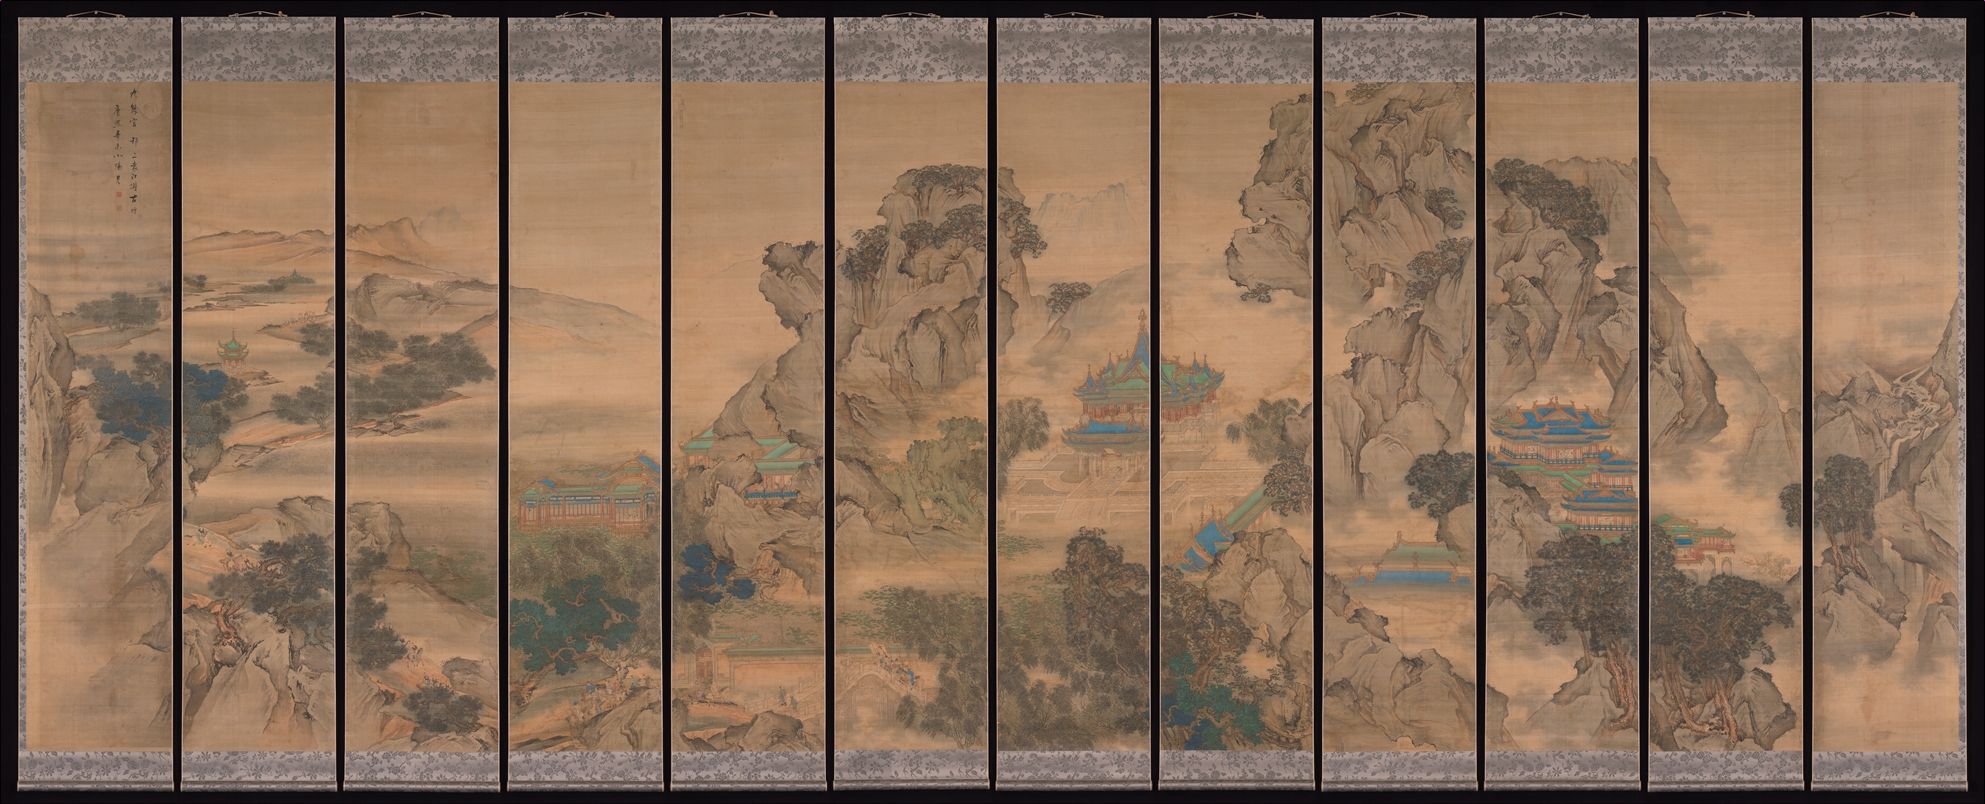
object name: hanging scroll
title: The Palace of Nine Perfections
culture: chinese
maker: yuan jiang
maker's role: artist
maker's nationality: chinese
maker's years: 1680-1730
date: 1691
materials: ink, silk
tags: palaces,landscapes